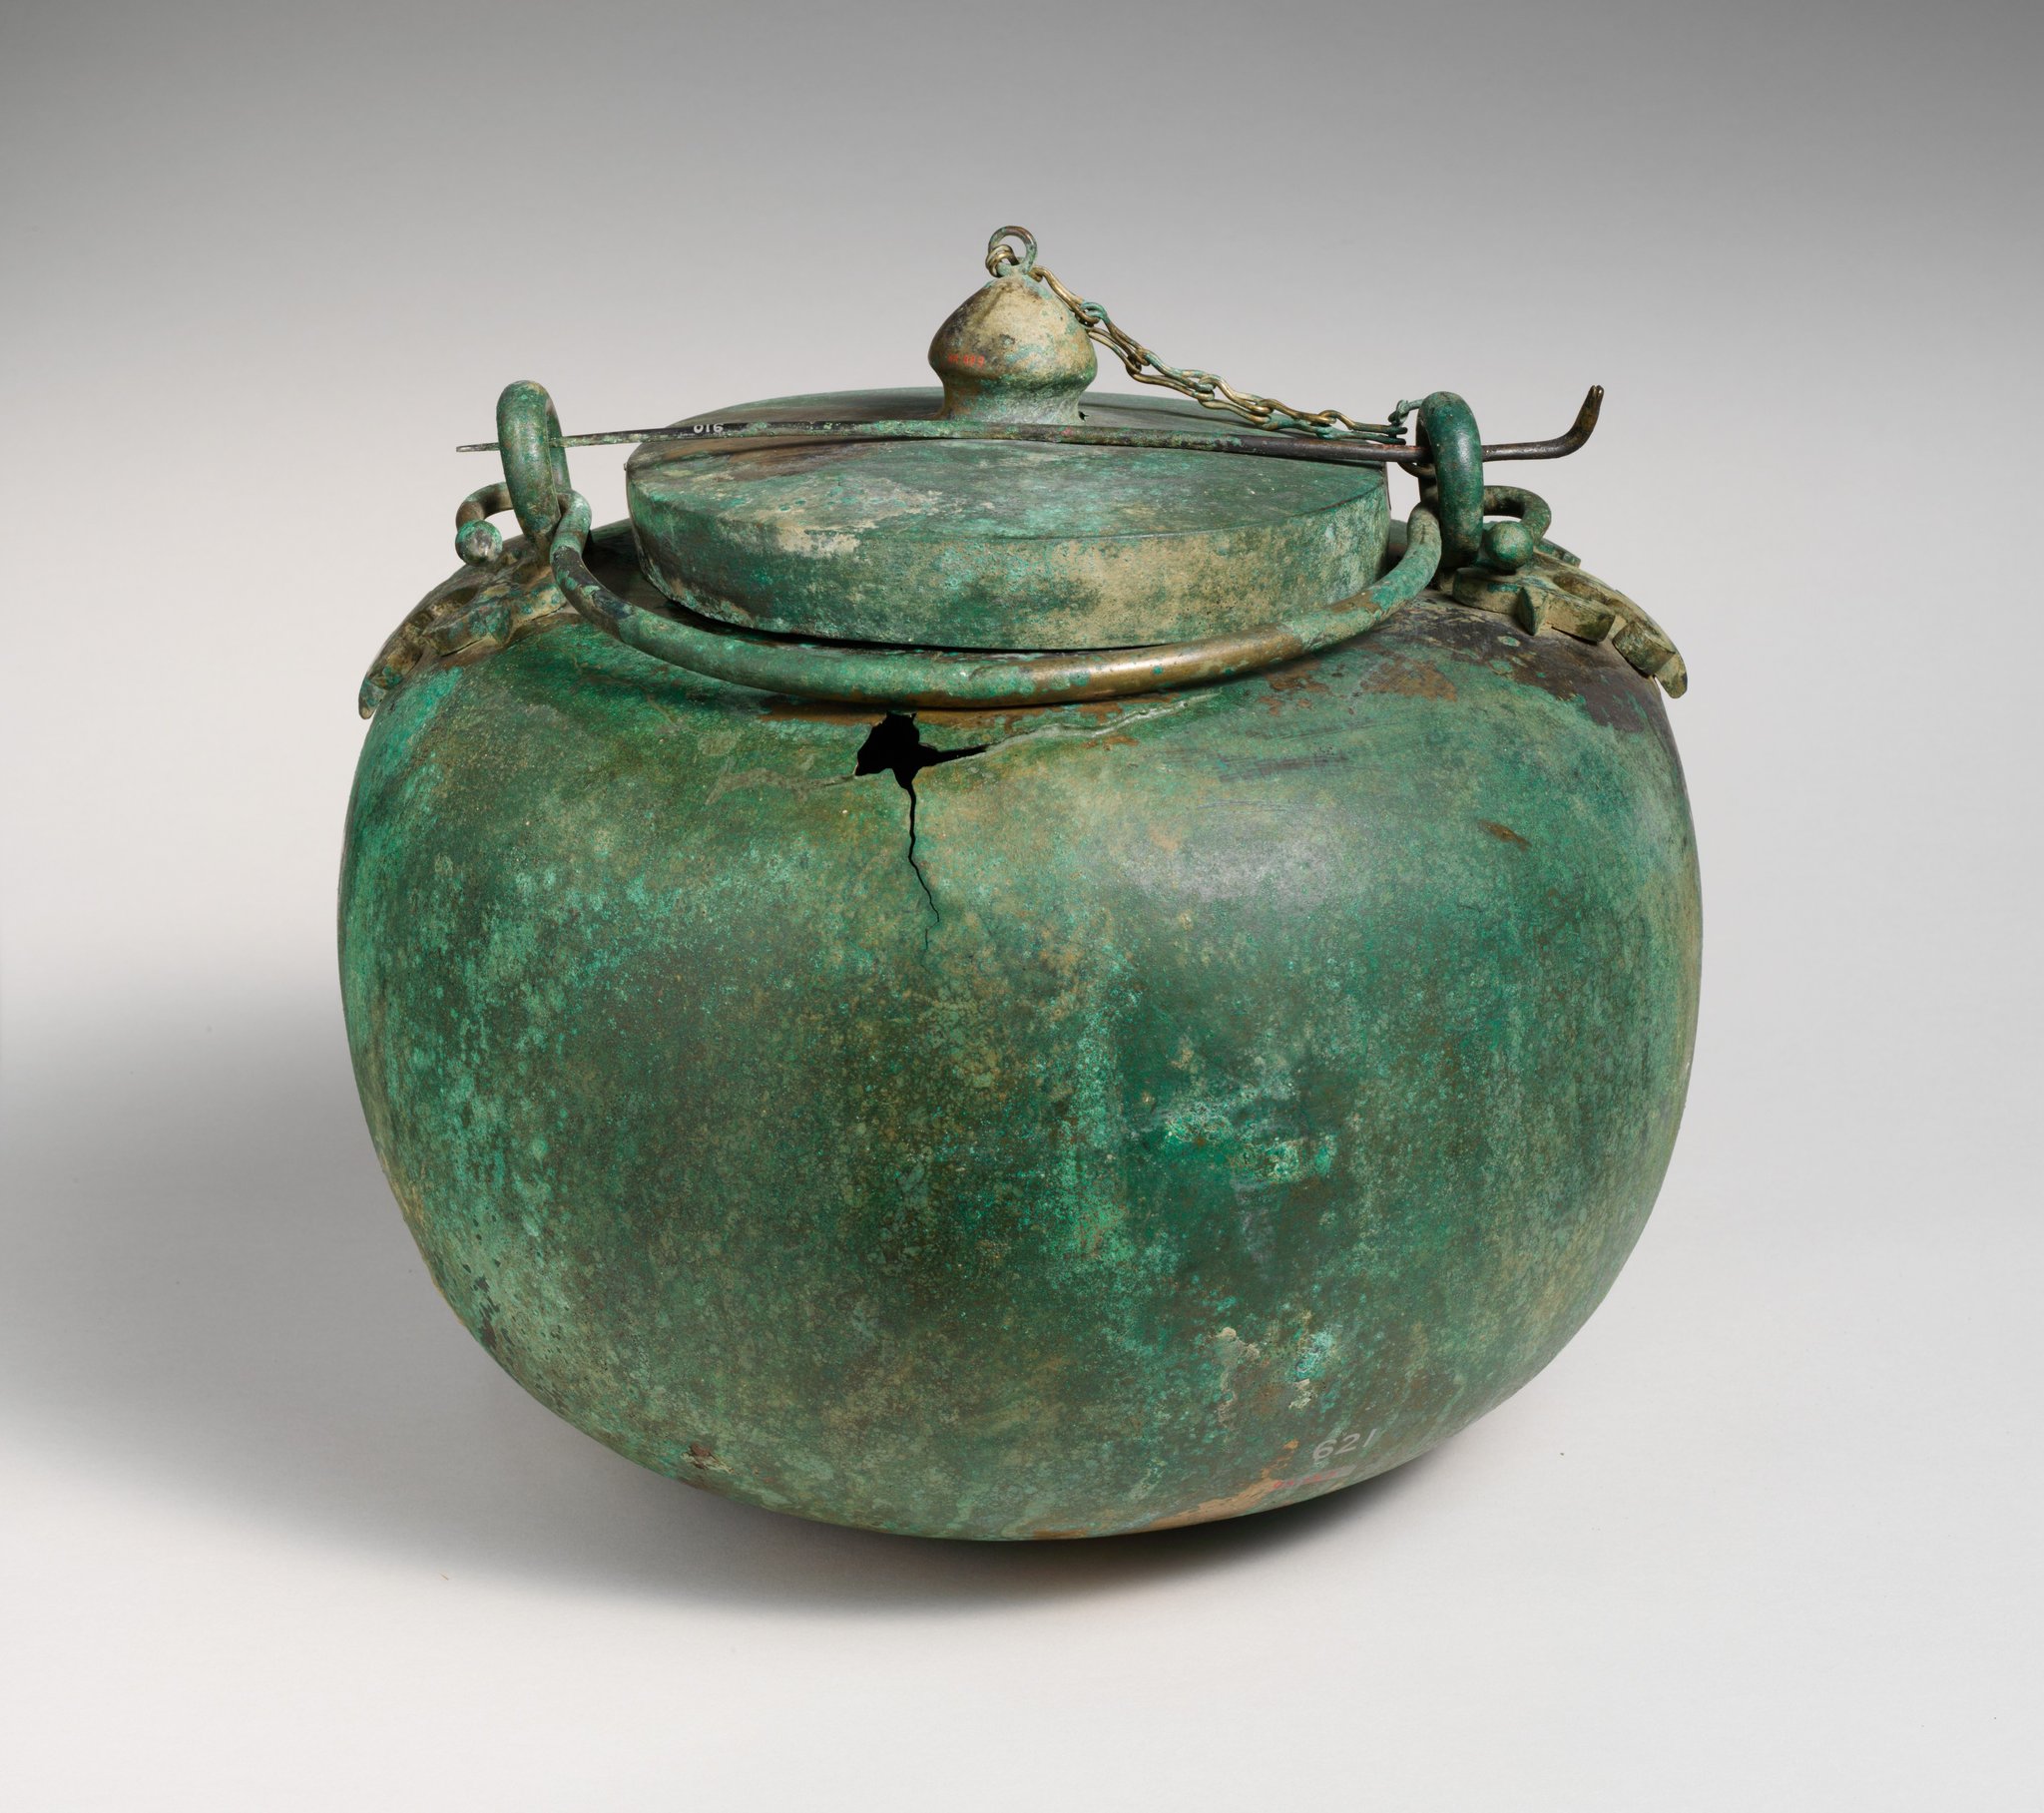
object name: cauldron with lid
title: Bronze cauldron and lid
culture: etruscan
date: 550 BCE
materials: bronze